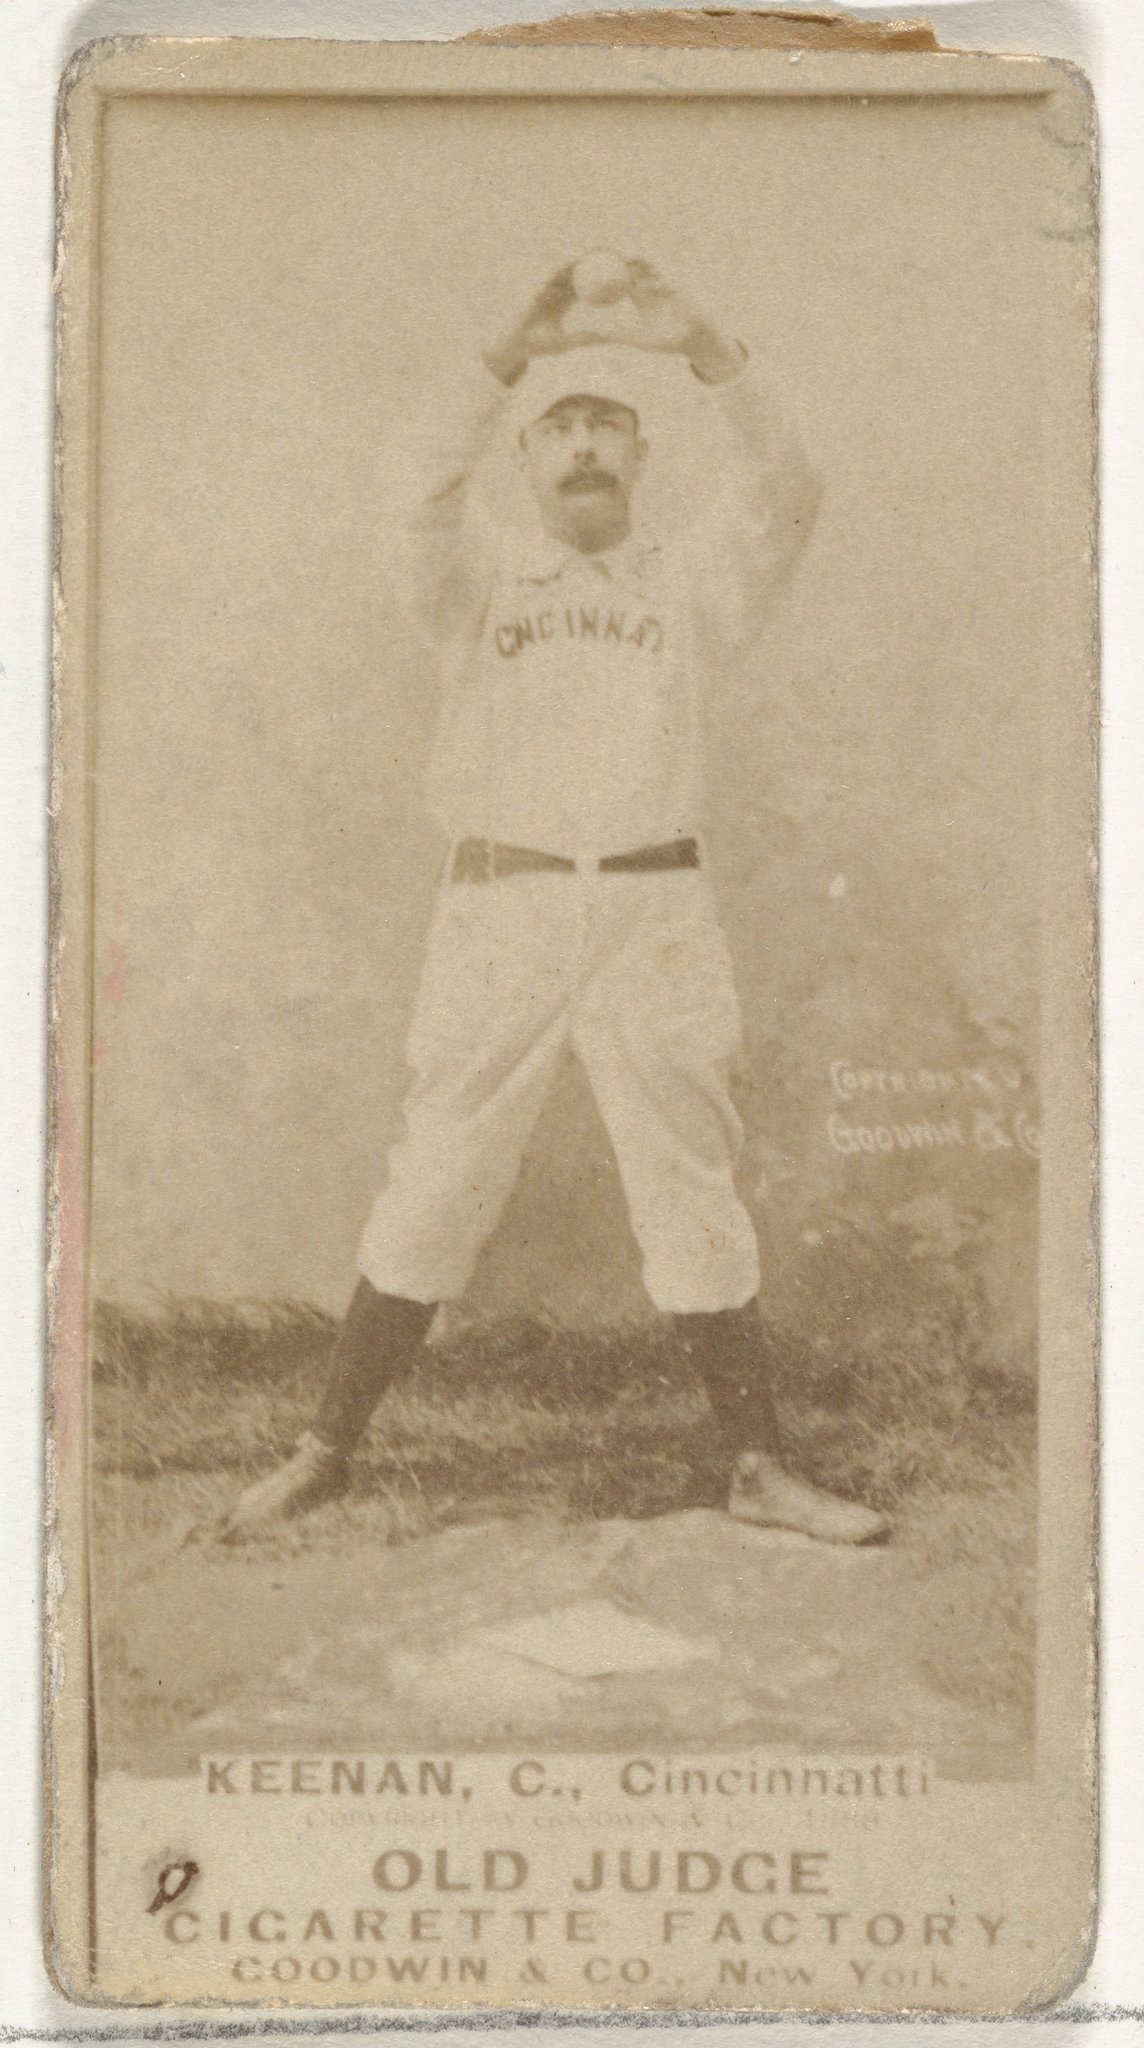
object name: baseball card, photograph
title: James William "Jim" Keenan, Catcher, Cincinnati, from the Old Judge series (N172) for Old Judge Cigarettes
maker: goodwin & company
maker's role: publisher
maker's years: 1850-1950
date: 1887-1890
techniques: albumen silver print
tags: men,portraits,baseball,athletes